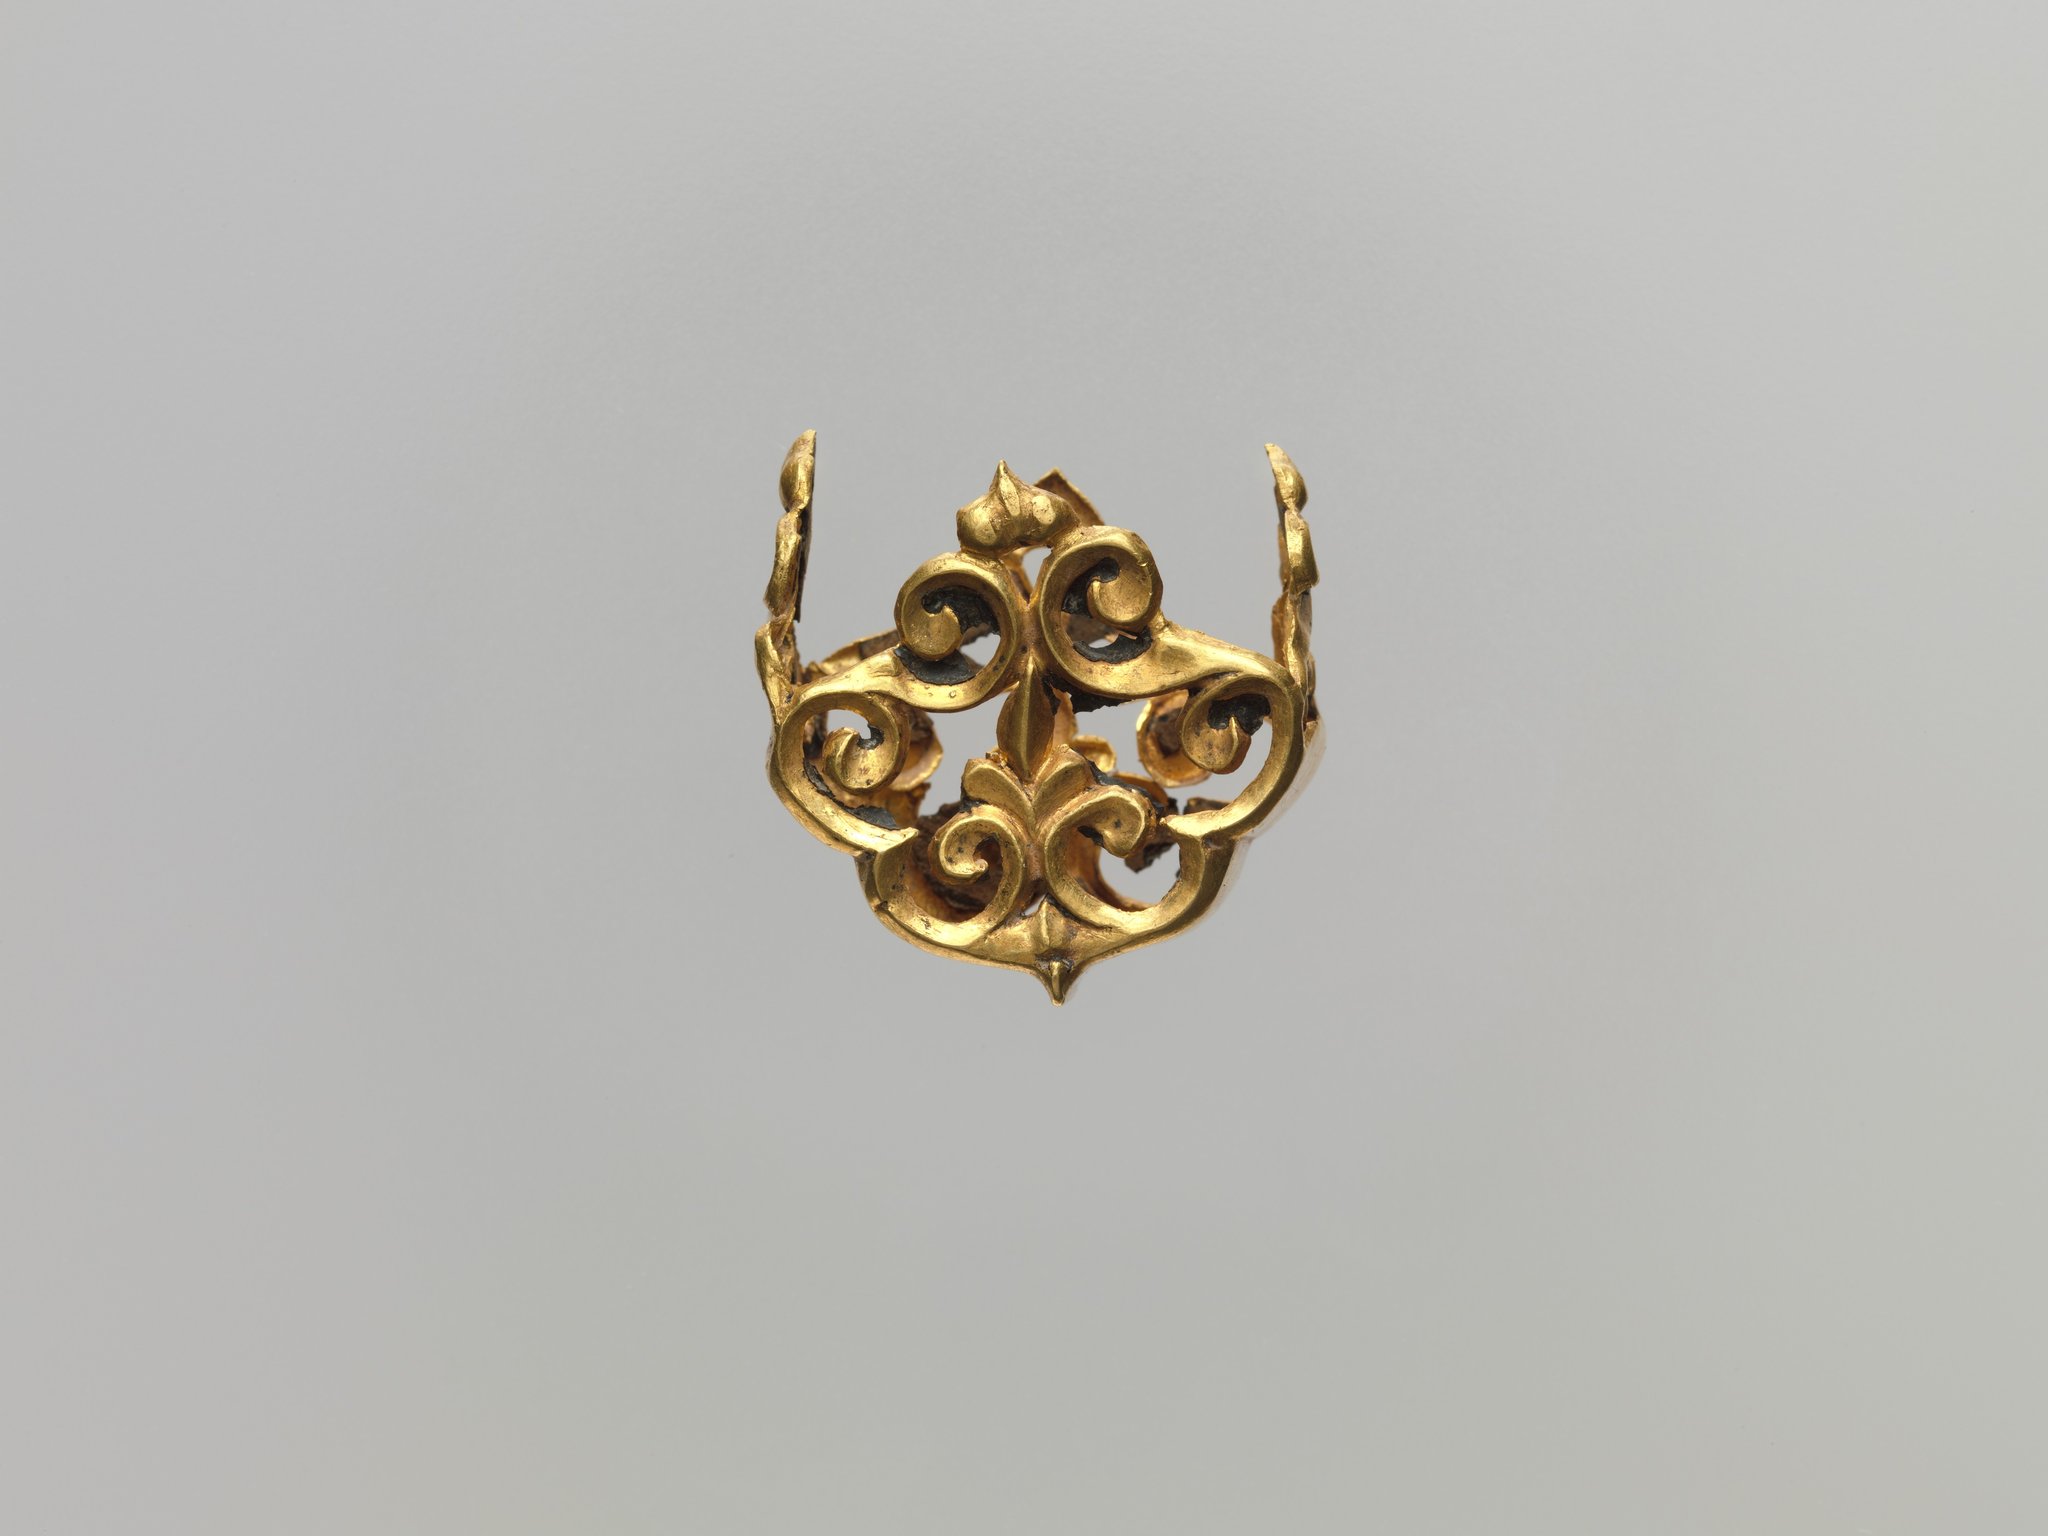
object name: fitting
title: Openwork Fitting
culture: chinese or central asian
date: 601-900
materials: gold